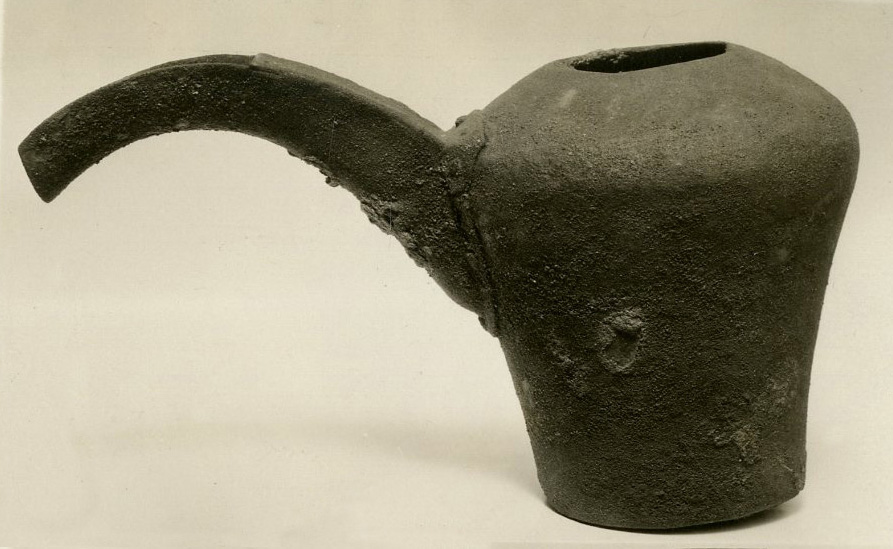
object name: vessel, ewer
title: Ewer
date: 2649-2100 BCE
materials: copper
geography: egypt